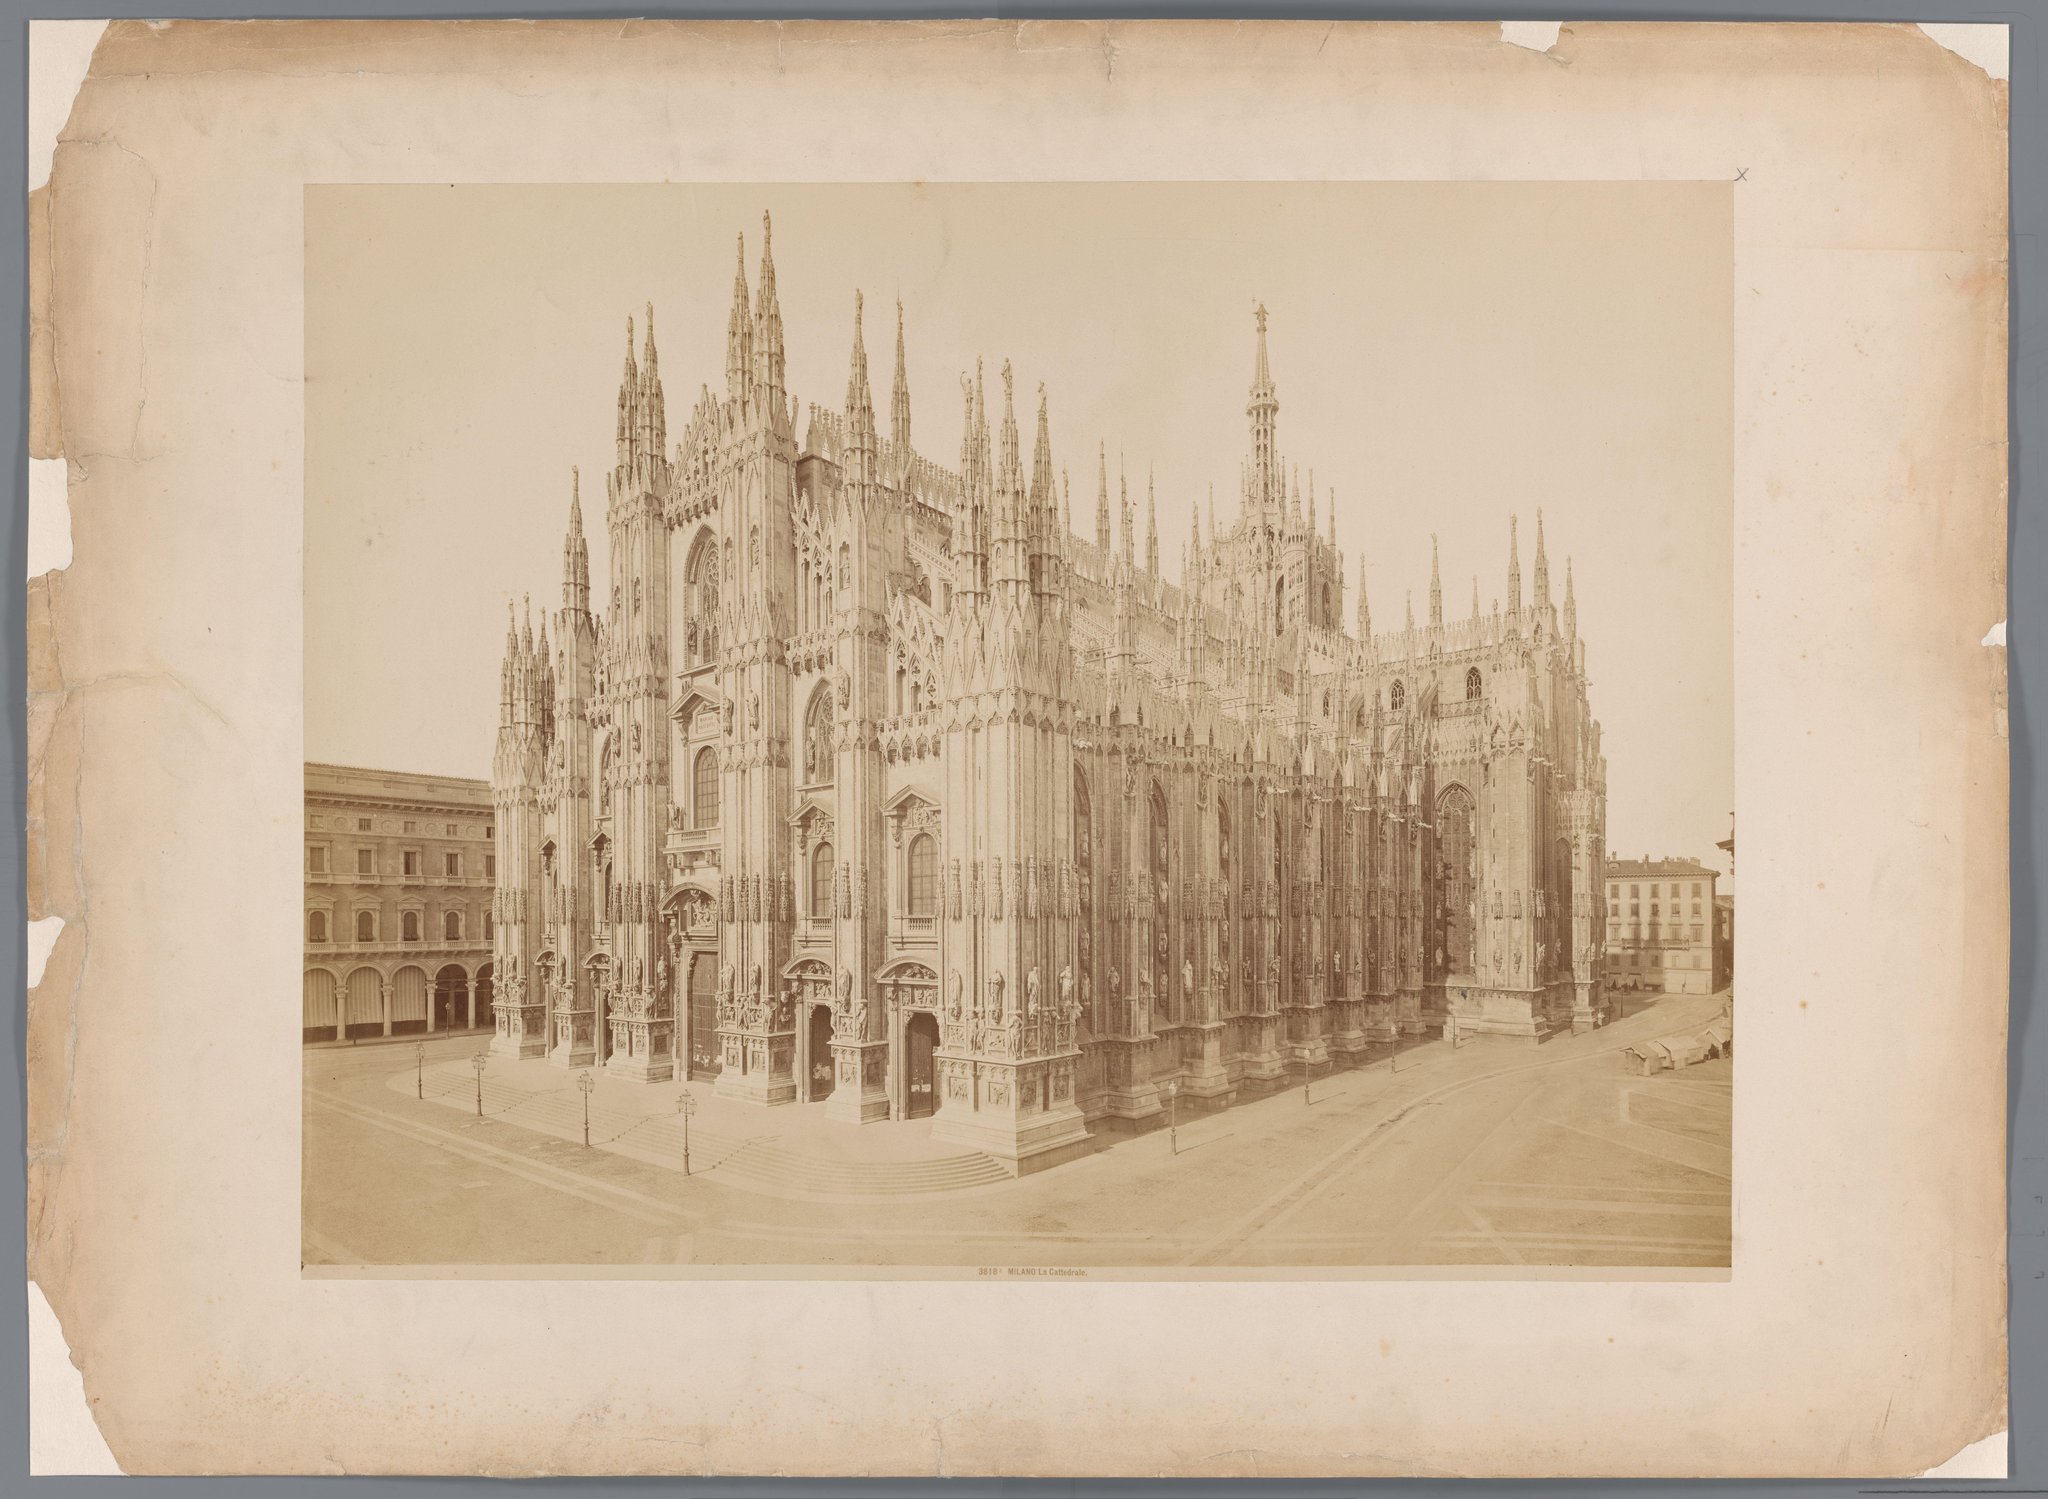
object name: photograph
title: De Dom te Milaan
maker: giacomo brogi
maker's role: fotograaf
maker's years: 1822-1881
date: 1895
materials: cardboard, paper, photographic support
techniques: albumen print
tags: dom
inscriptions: : ‘3818a MILANO La Cattedrale.’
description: West- en Zuidgevel van de Dom te Milaan.